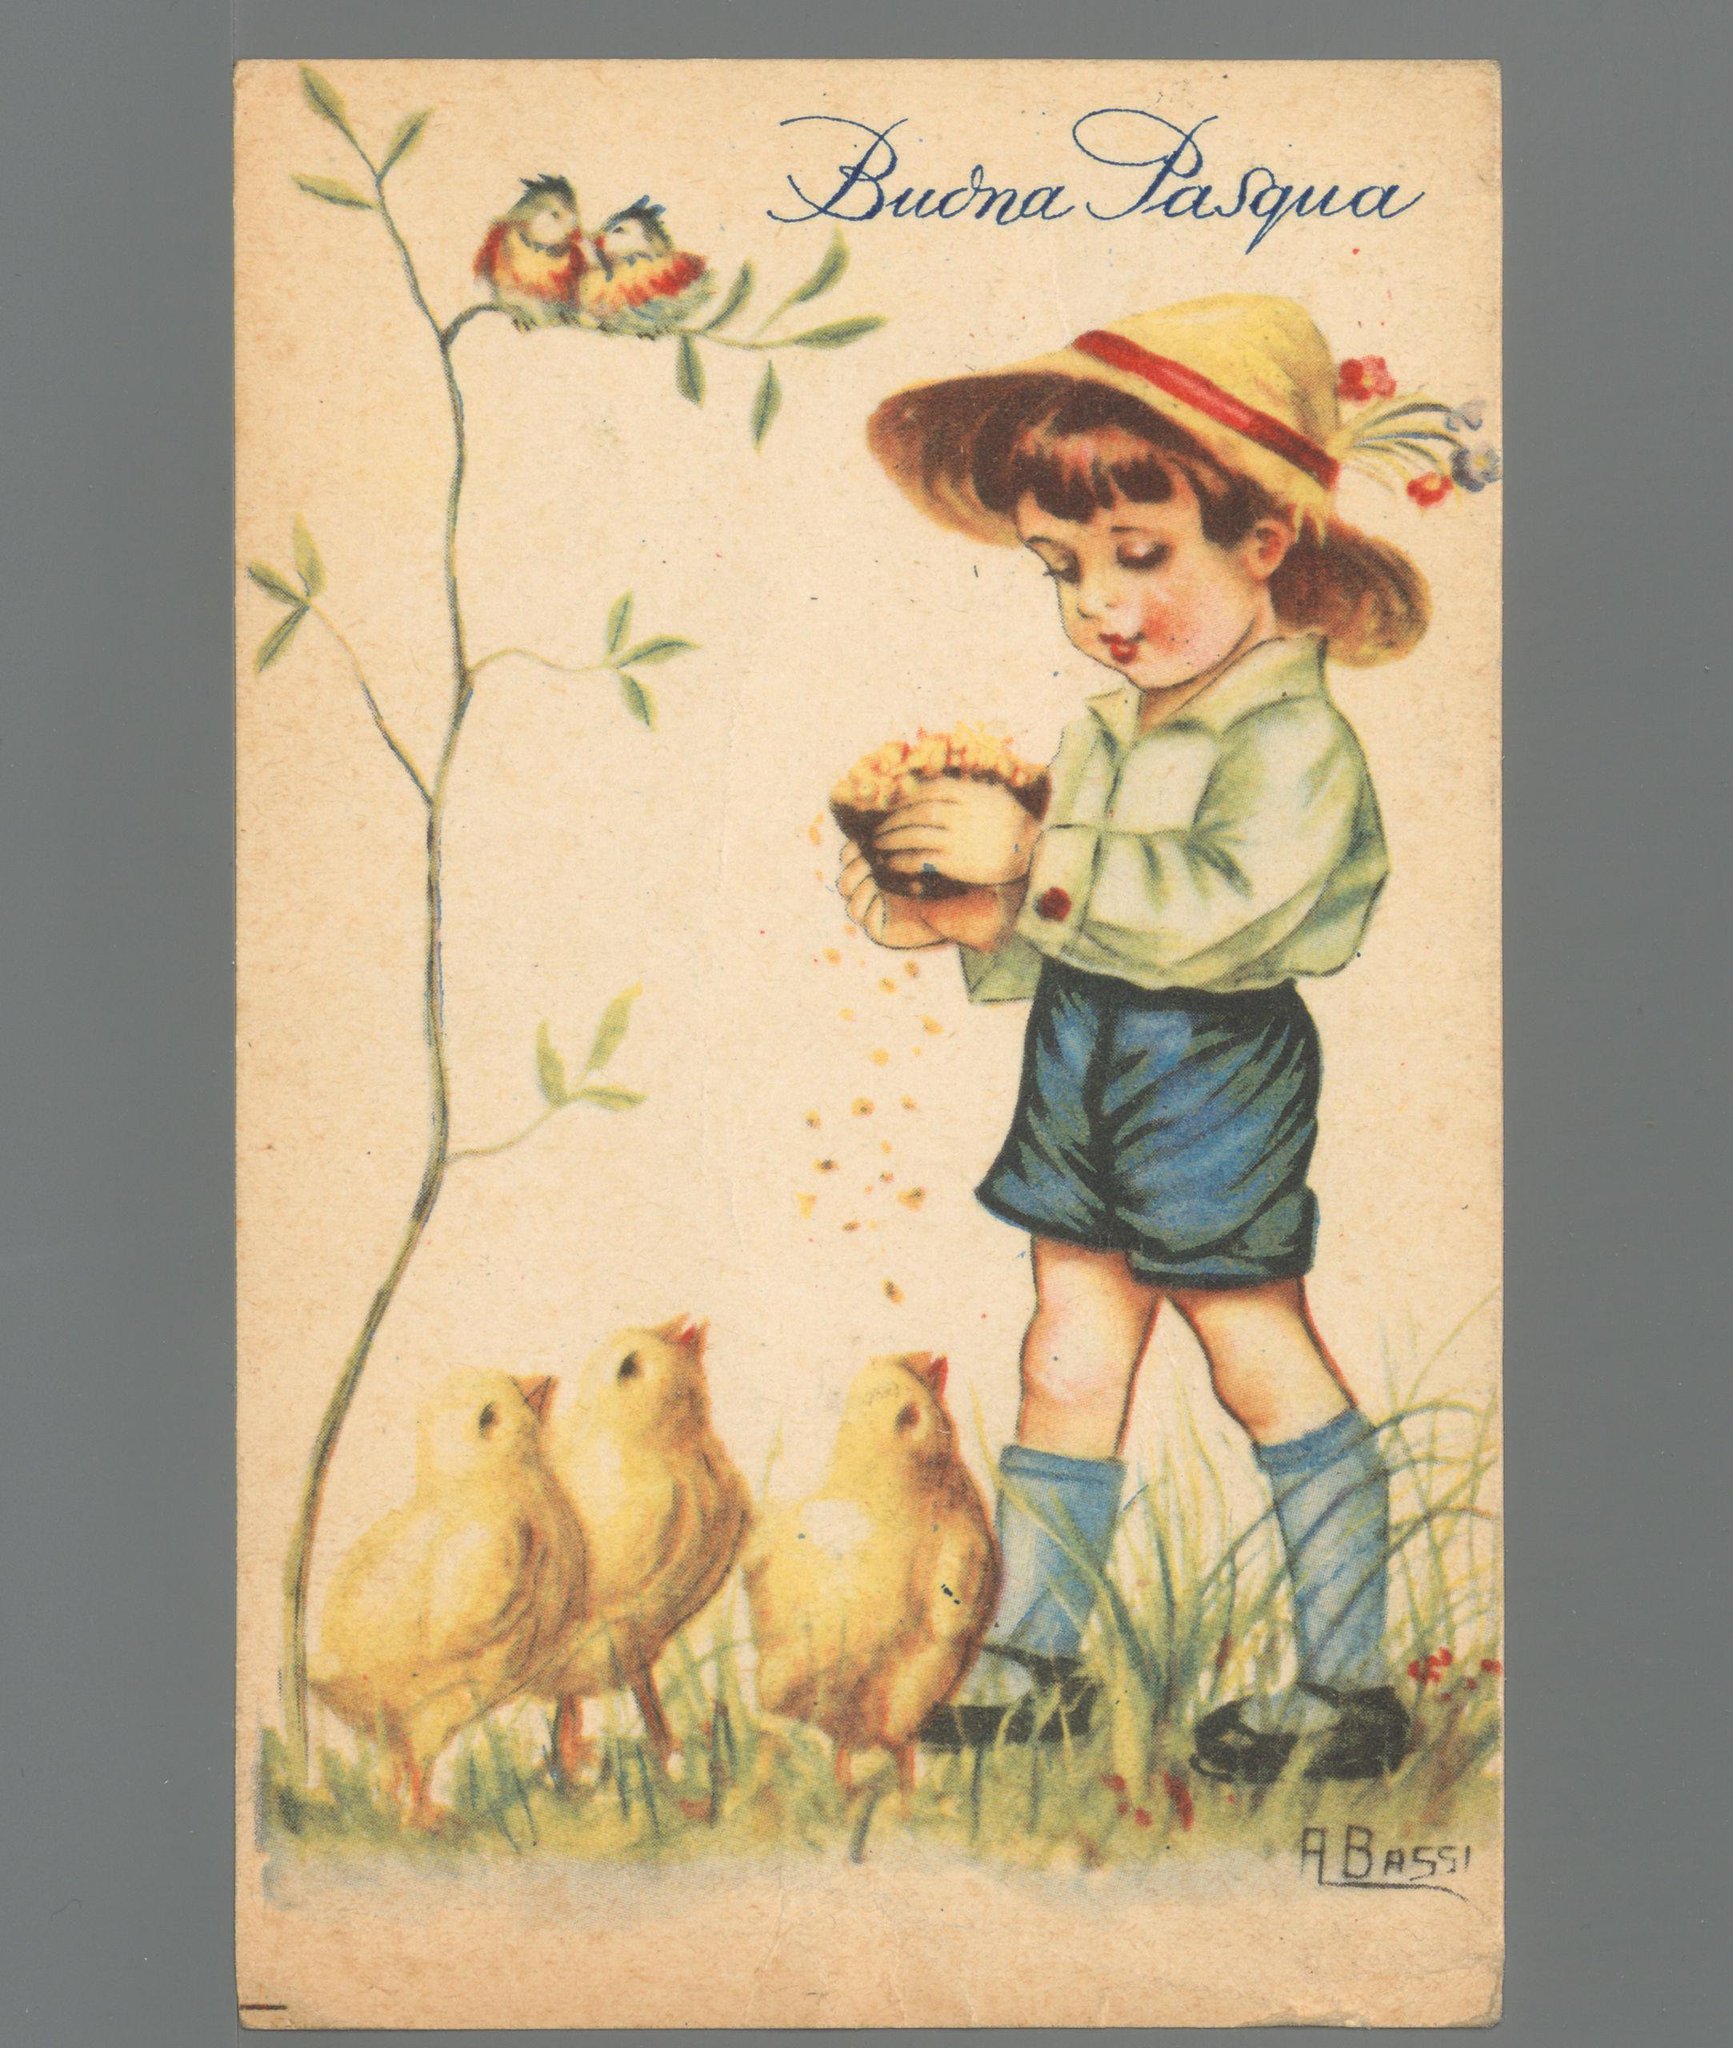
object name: photomechanical print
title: Buona Pasqua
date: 1935-1951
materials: cardboard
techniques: writing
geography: milan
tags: giving food, children's games and plays, birds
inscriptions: postage stamp